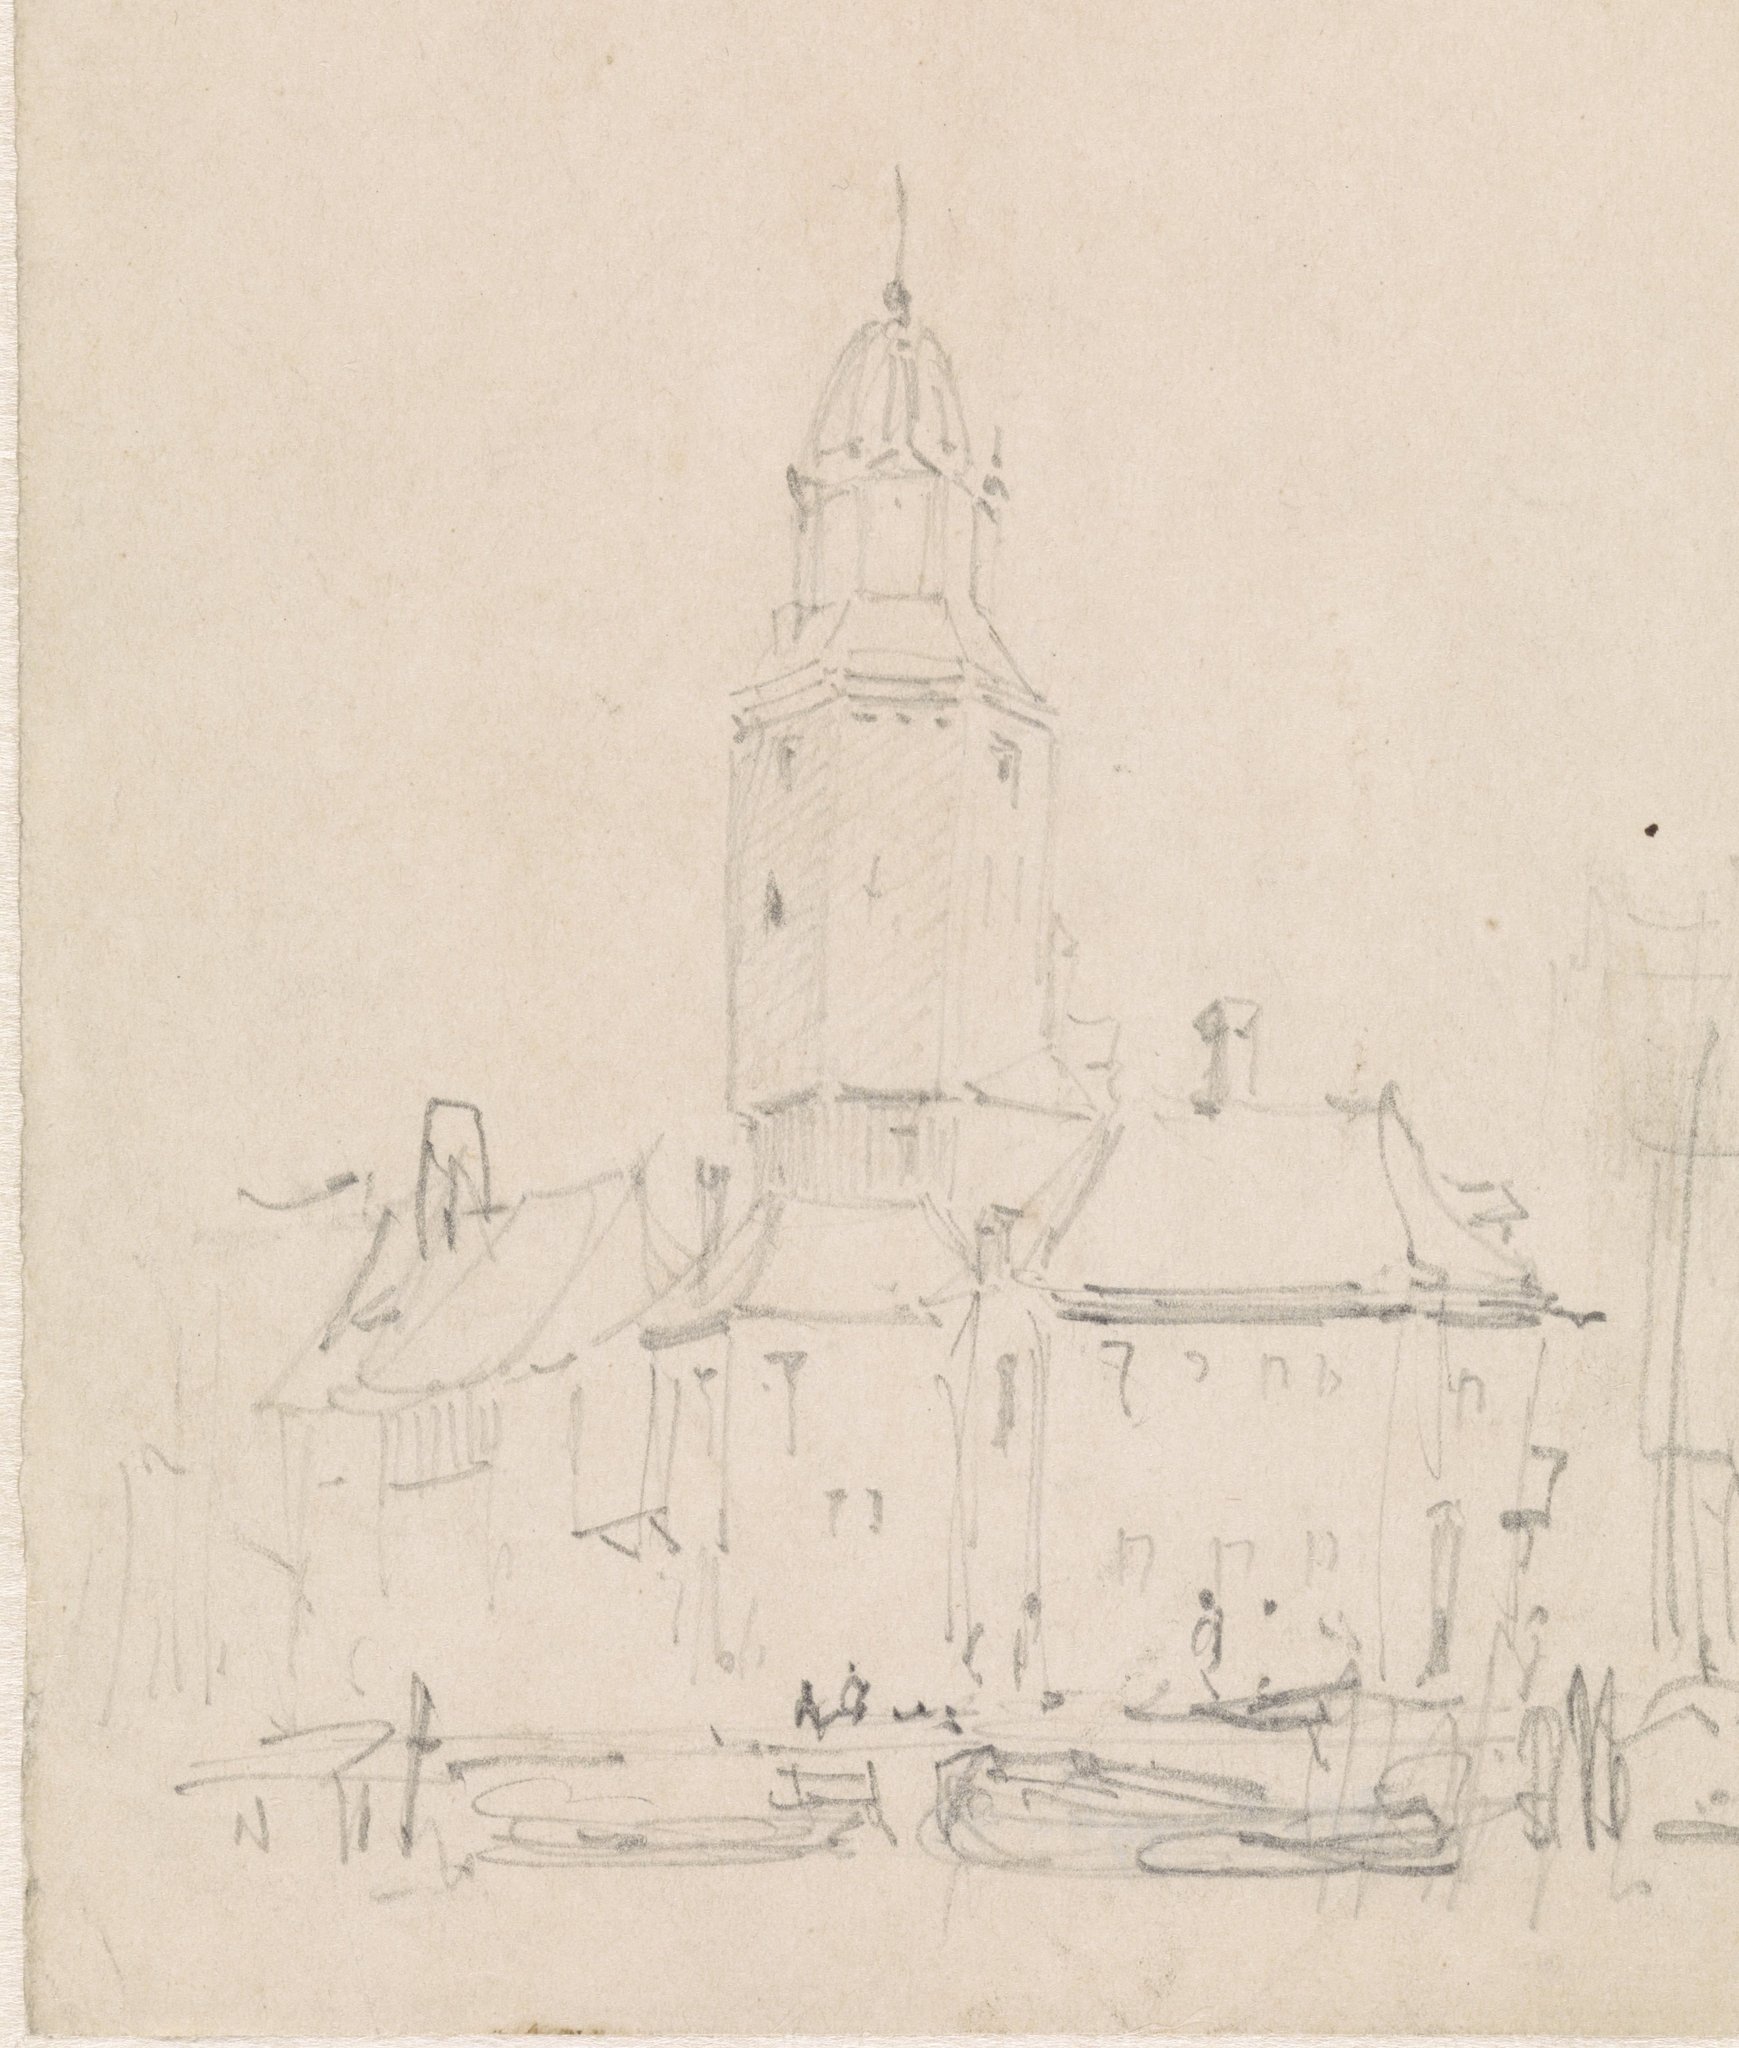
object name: drawing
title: Stadsgezicht met toren bij huizen aan de kade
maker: adrianus eversen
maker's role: draughtsman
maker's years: 1818-1897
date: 1828-1897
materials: paper, pencil